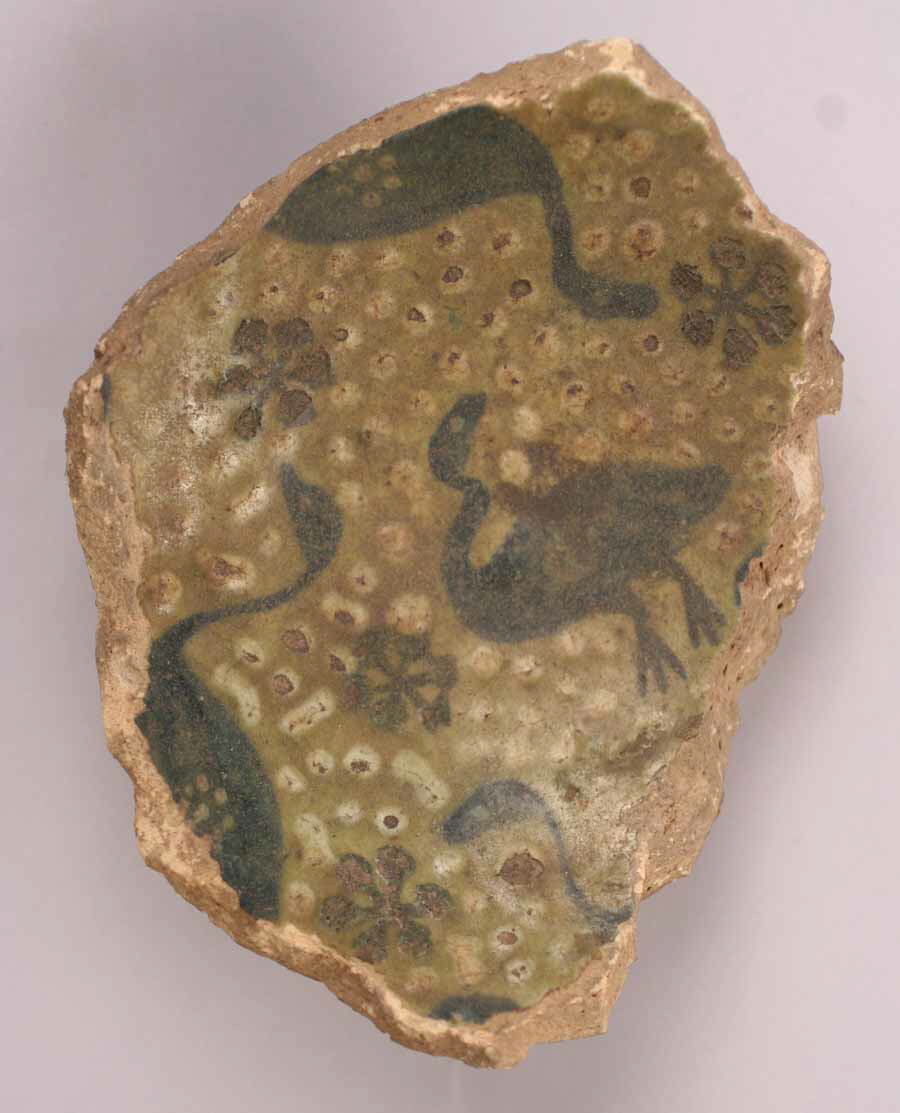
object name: fragment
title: Ceramic Fragment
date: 1301-1500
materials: stonepaste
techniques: painting, underglaze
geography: egypt